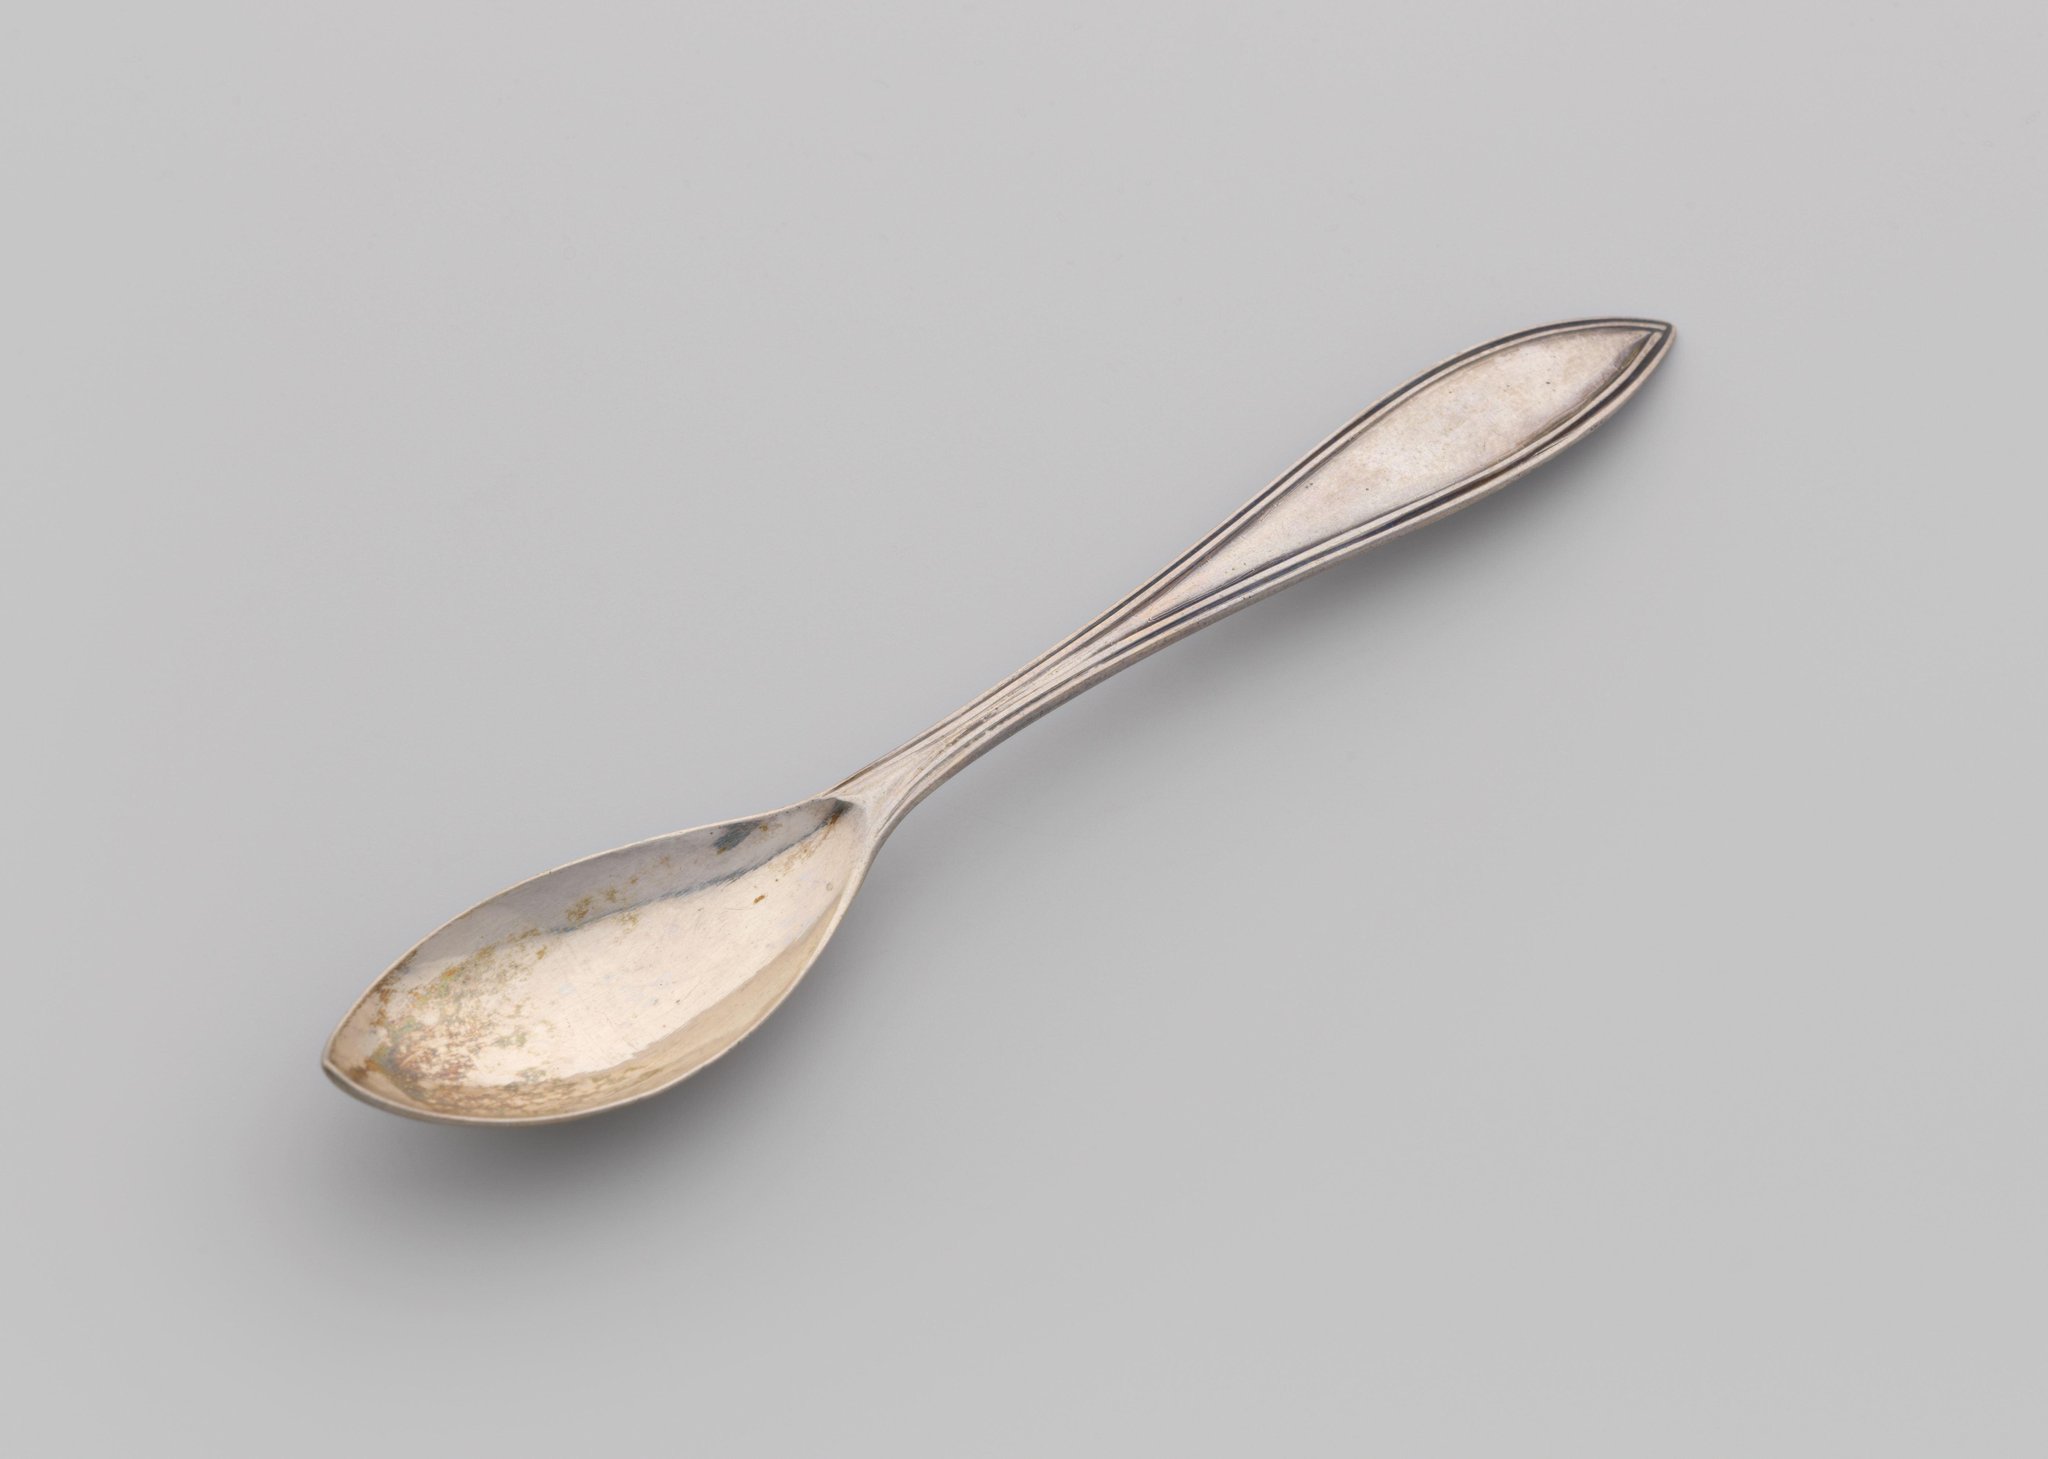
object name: teaspoon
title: Theelepel van zilver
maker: jan woortman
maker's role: silversmith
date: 1804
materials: silver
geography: amsterdam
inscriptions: mark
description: Theelepel van zilver, met een spits ovale bak. De platte, gebogen steel verbreedt zich naar het spitse uiteinde dat omgeven wordt door een filetrand.